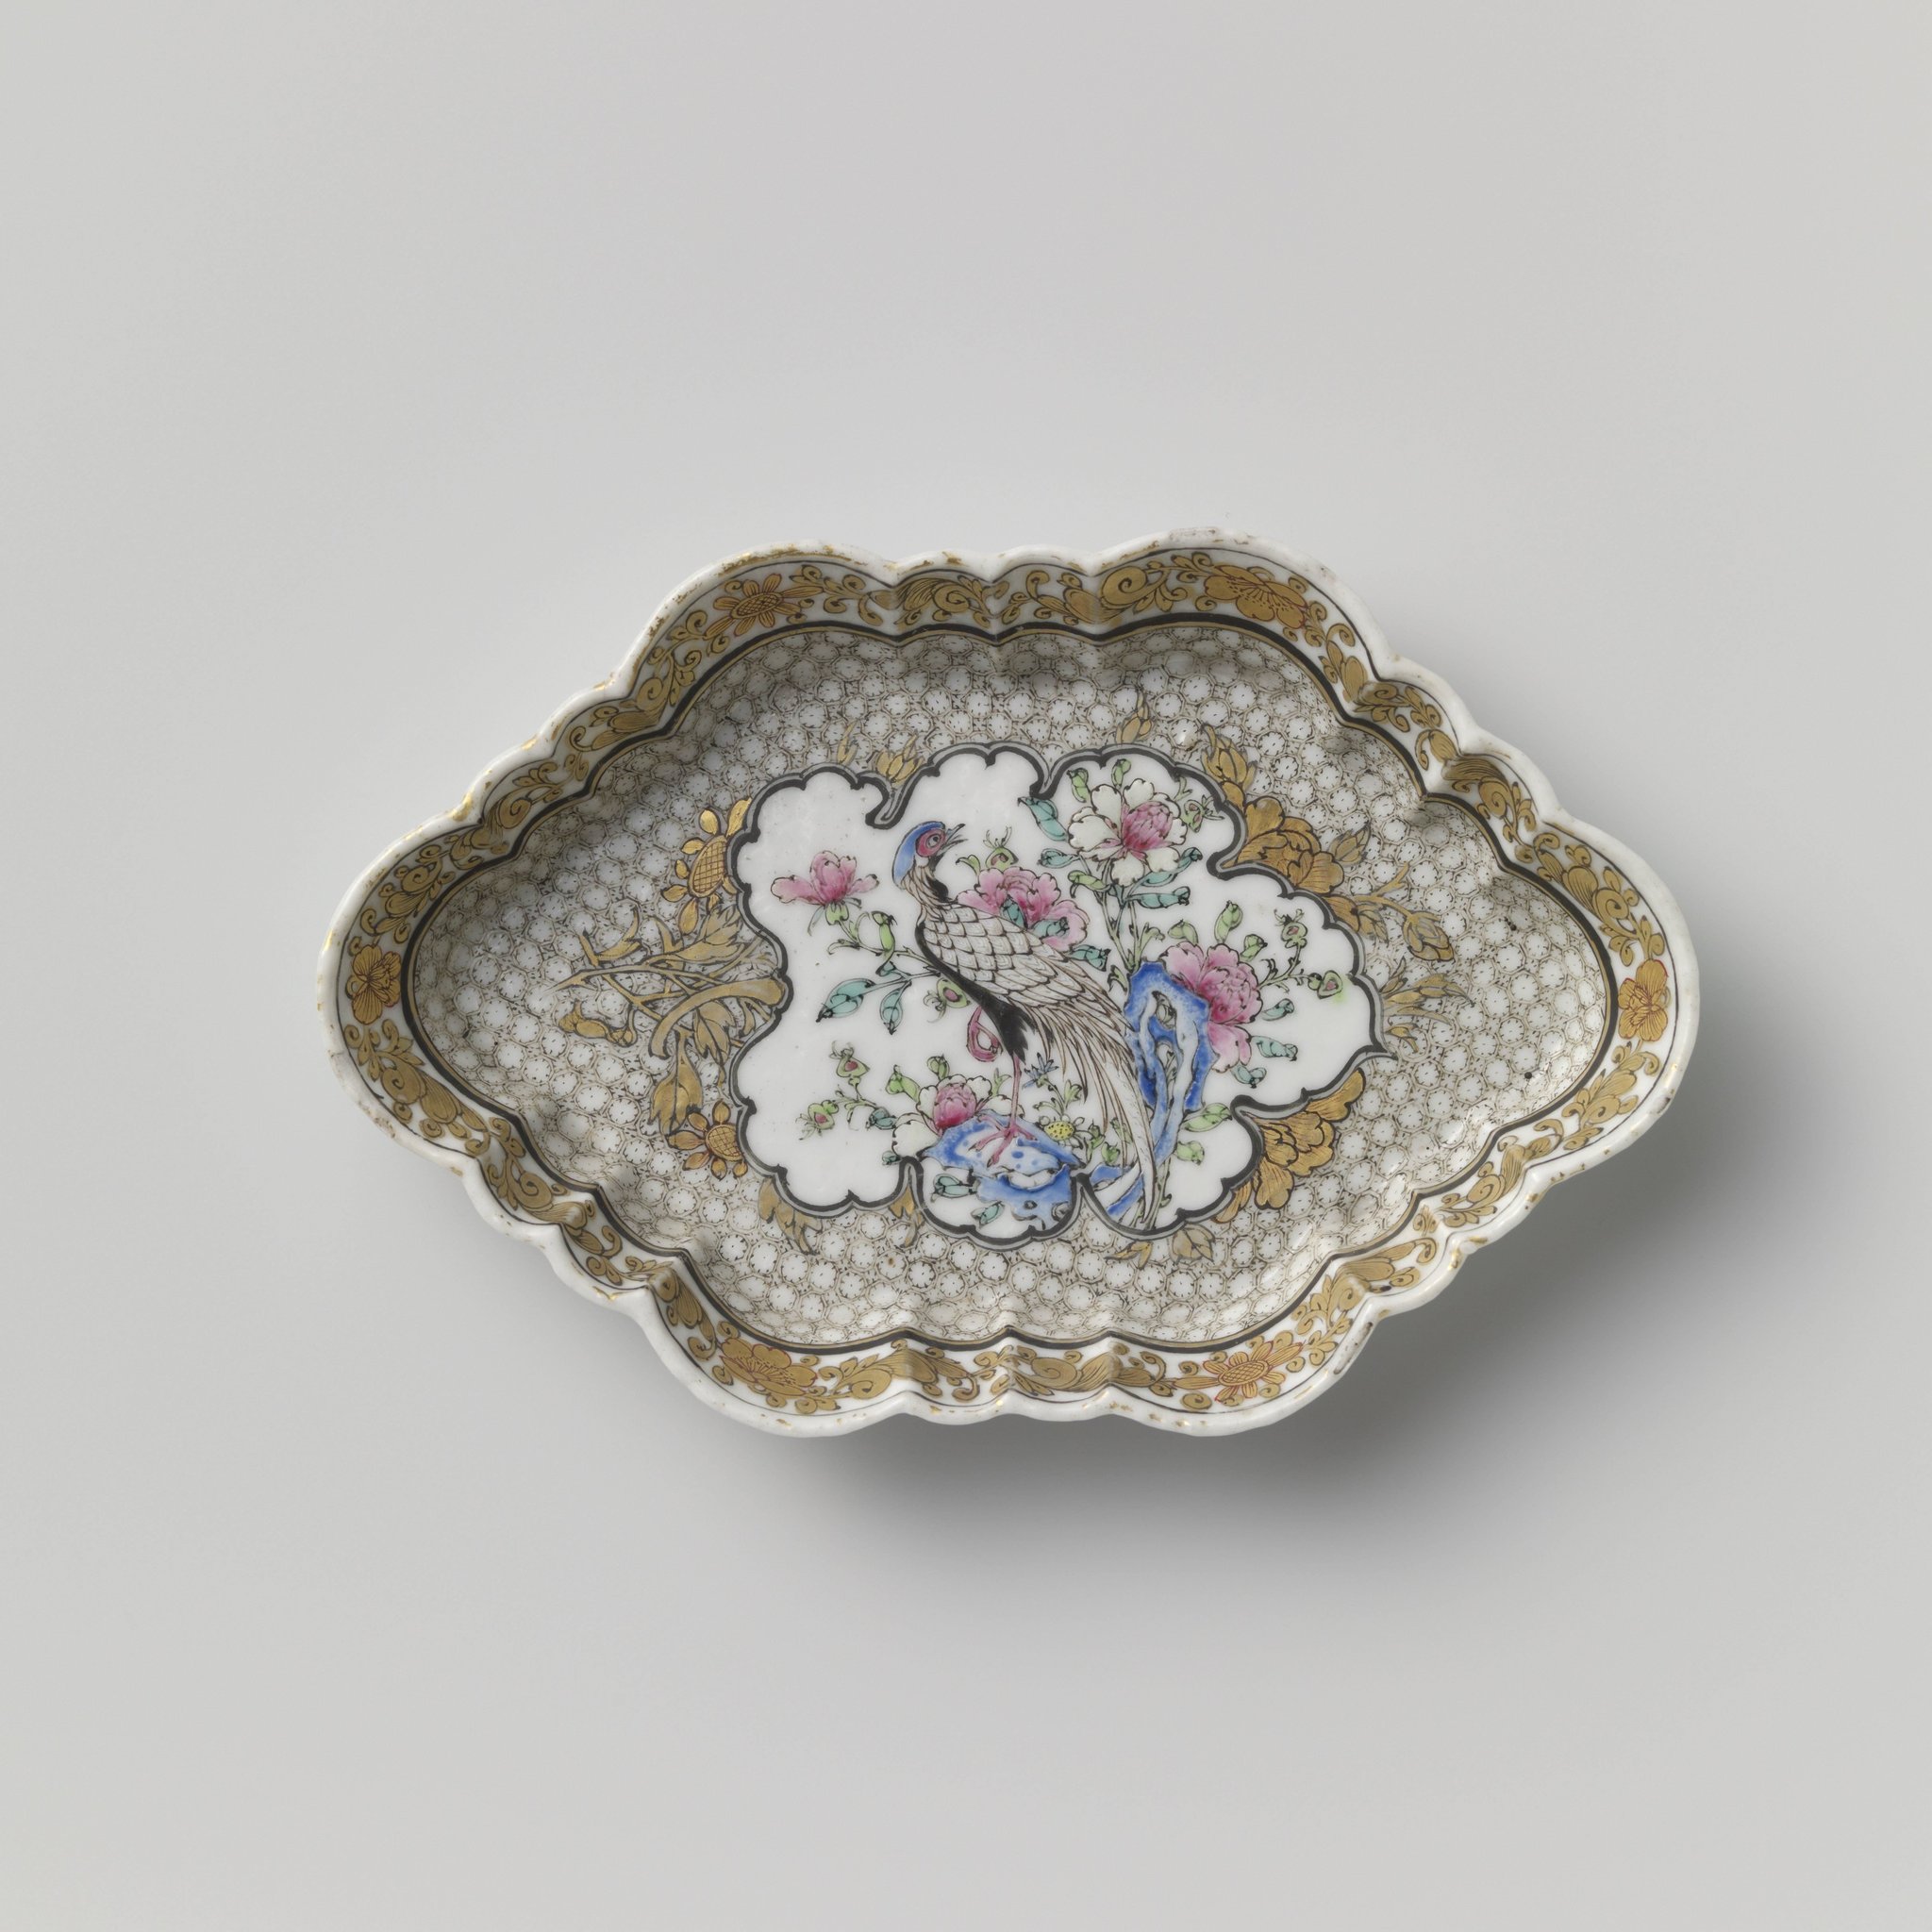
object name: pattipan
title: Spoon tray with a pheasant on a rock and flower scrolls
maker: Anonymous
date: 1725-1749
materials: glaze, gold, paint, porcelain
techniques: firing, forming, gilding, vitrification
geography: china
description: Schotel,met gekartelde rand versierd met goud en zwarten rand en in famille rose kleuren een fazant.